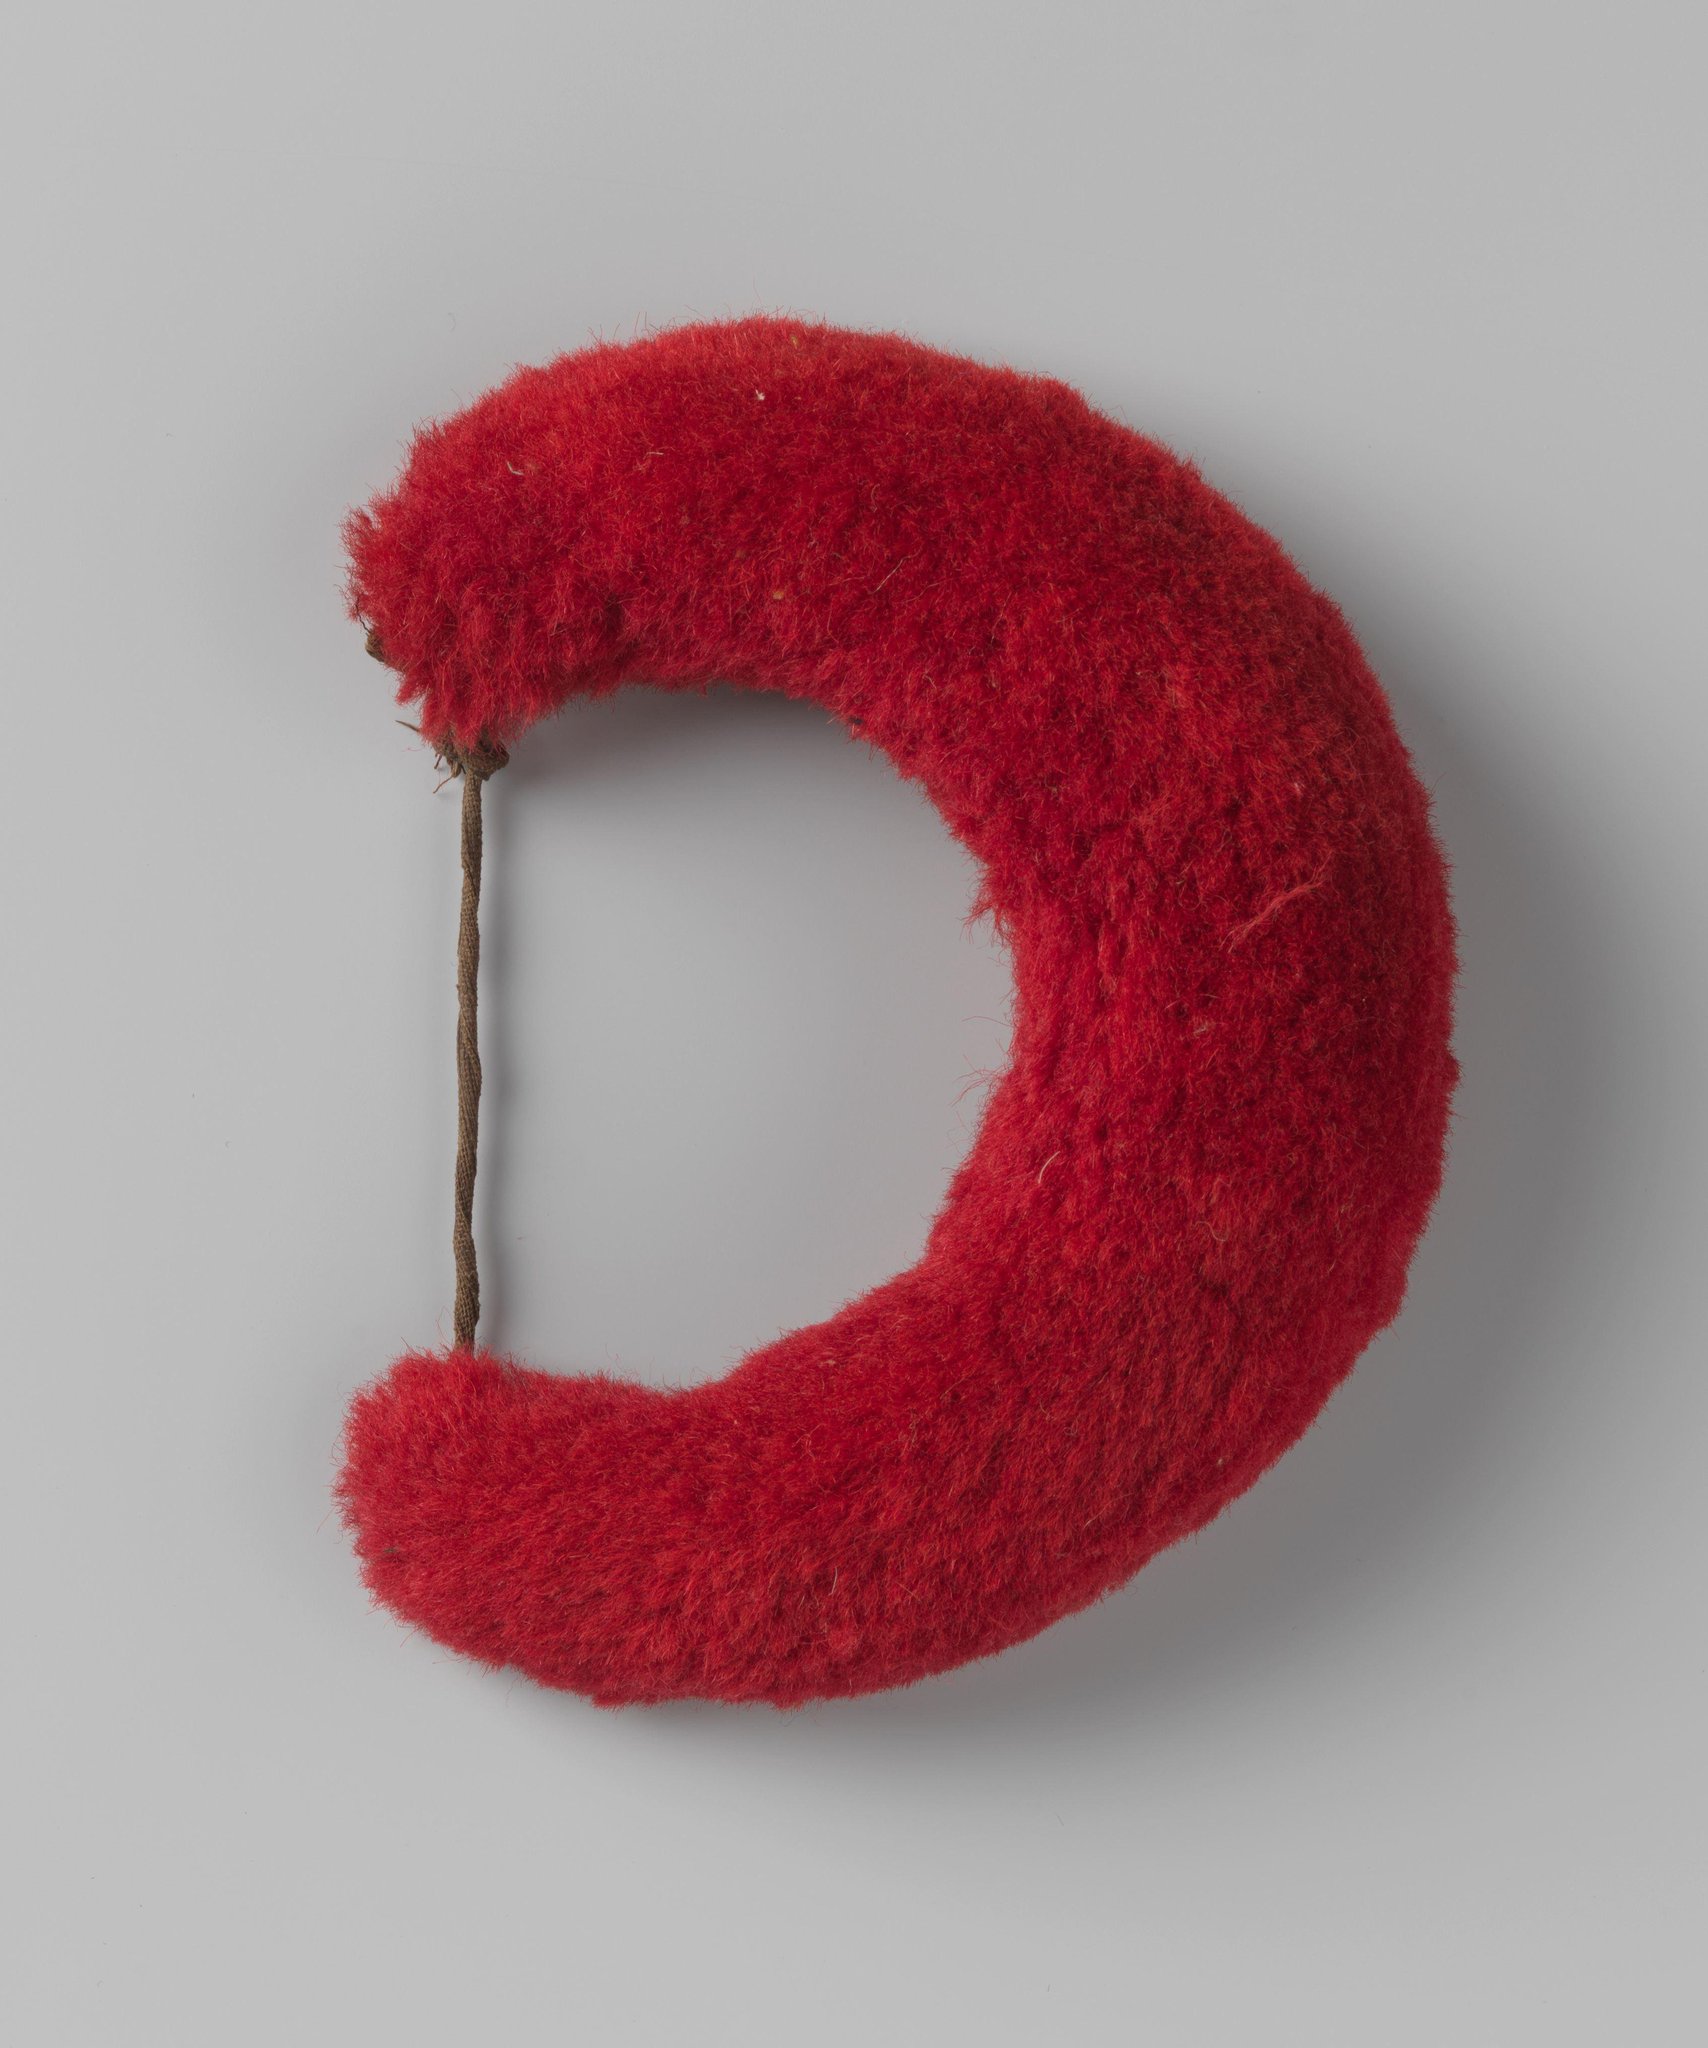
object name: wing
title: Wings, halfrond van rood wol met grijze lakense voering, voor schutters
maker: Anonymous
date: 1840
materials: textile, hair, wool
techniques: stitching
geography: netherlands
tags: netherlands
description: Een half ronde, rood wollen schouderbedekkingen met grijze lakense voering. De schouderbedekking is deels beschadigd, waardoor haren uit de vulling steken. Aan de wings zitten twee veters en een lus ter bevestiging van de uniformjas.